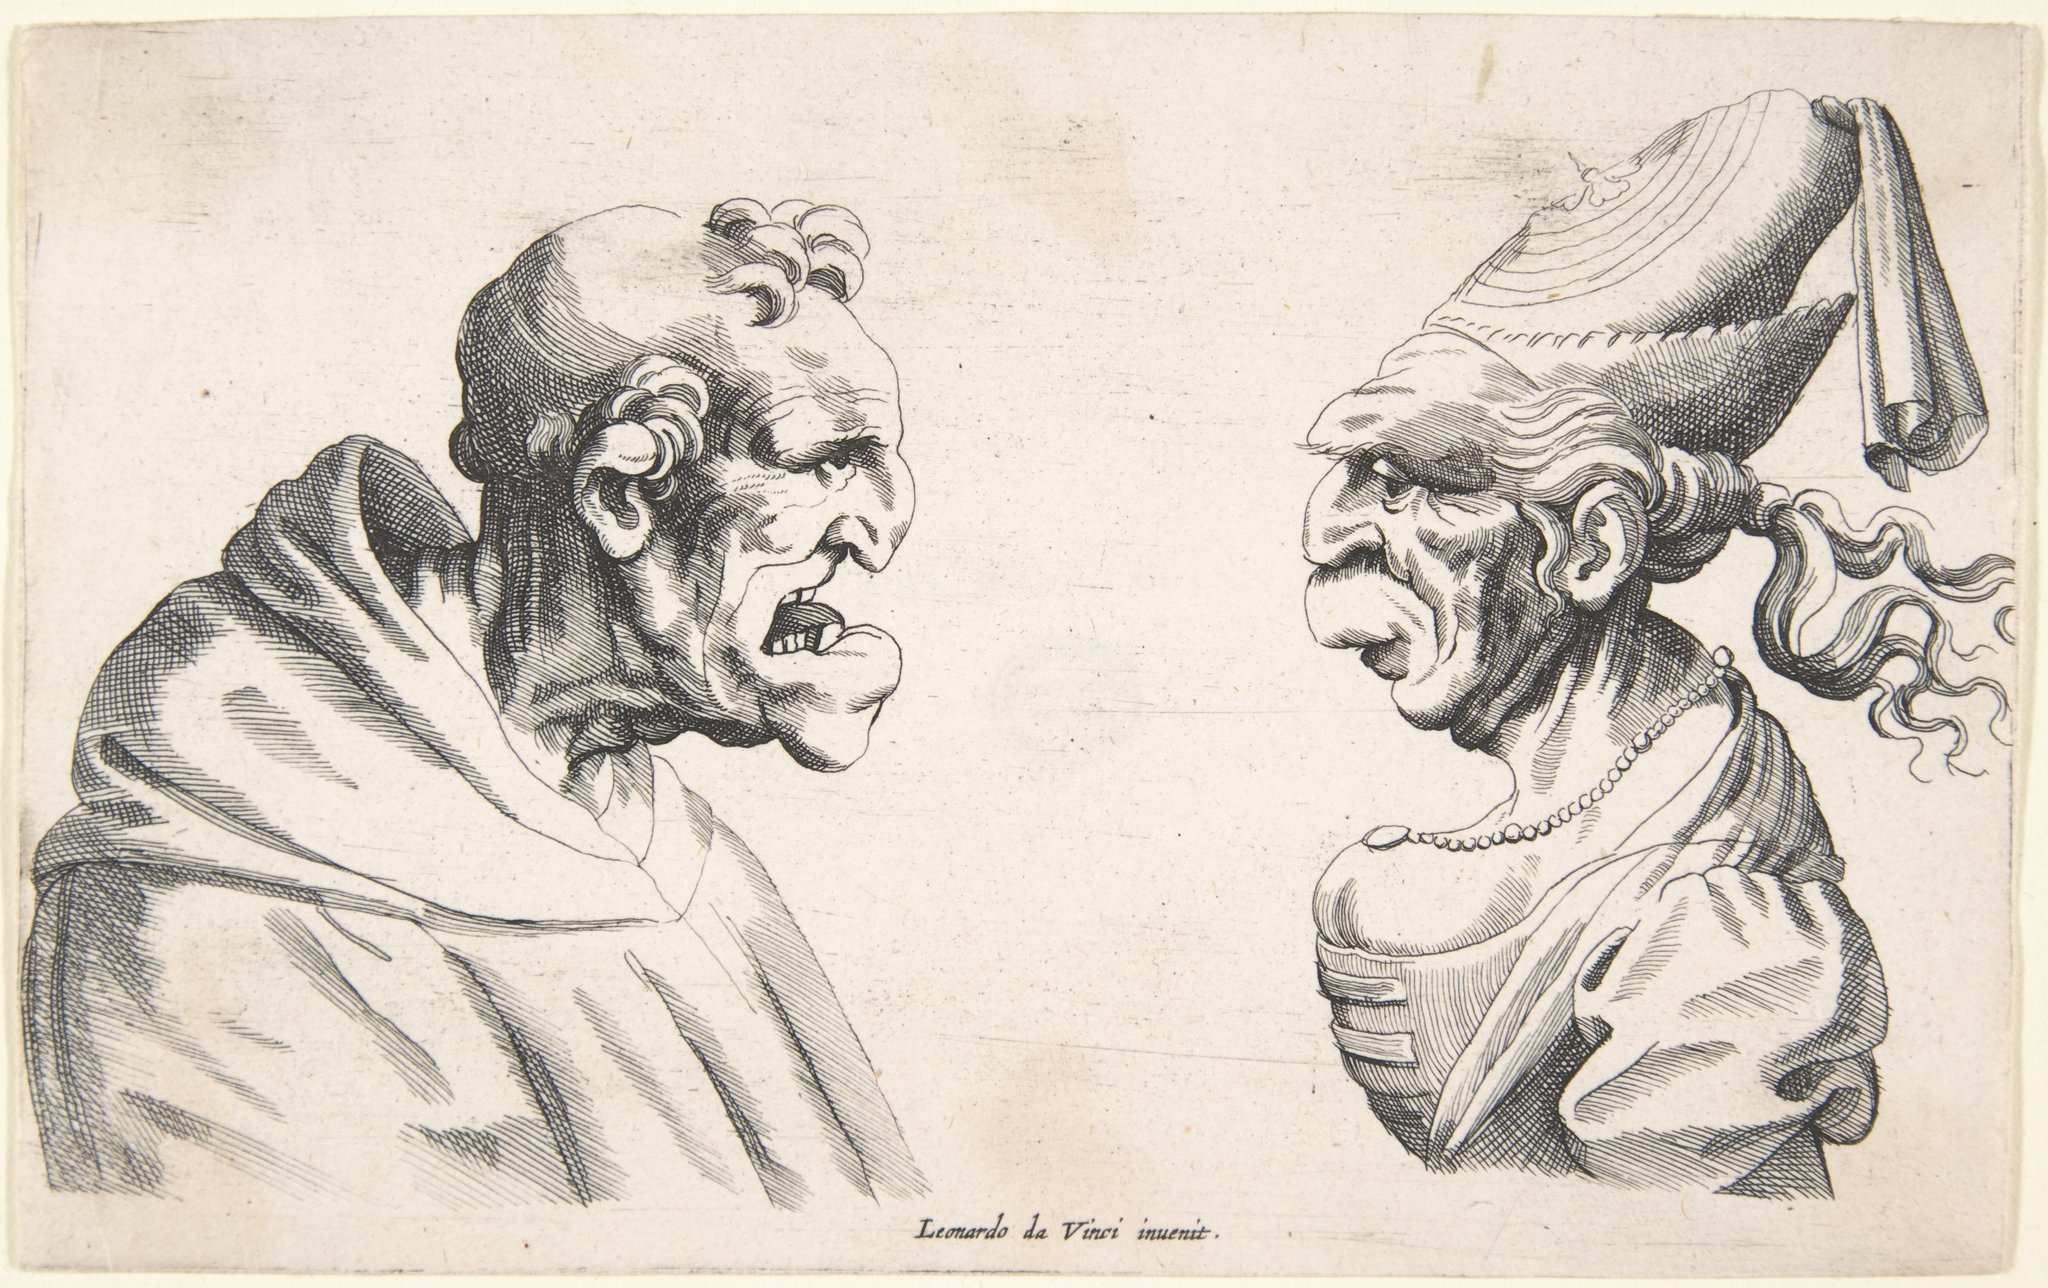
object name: print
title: Two Grotesque Heads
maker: anonymous, netherlandish, 17th century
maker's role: artist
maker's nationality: netherlandish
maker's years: 1600-1700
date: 1640-1649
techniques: etching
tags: heads,men,profiles,women